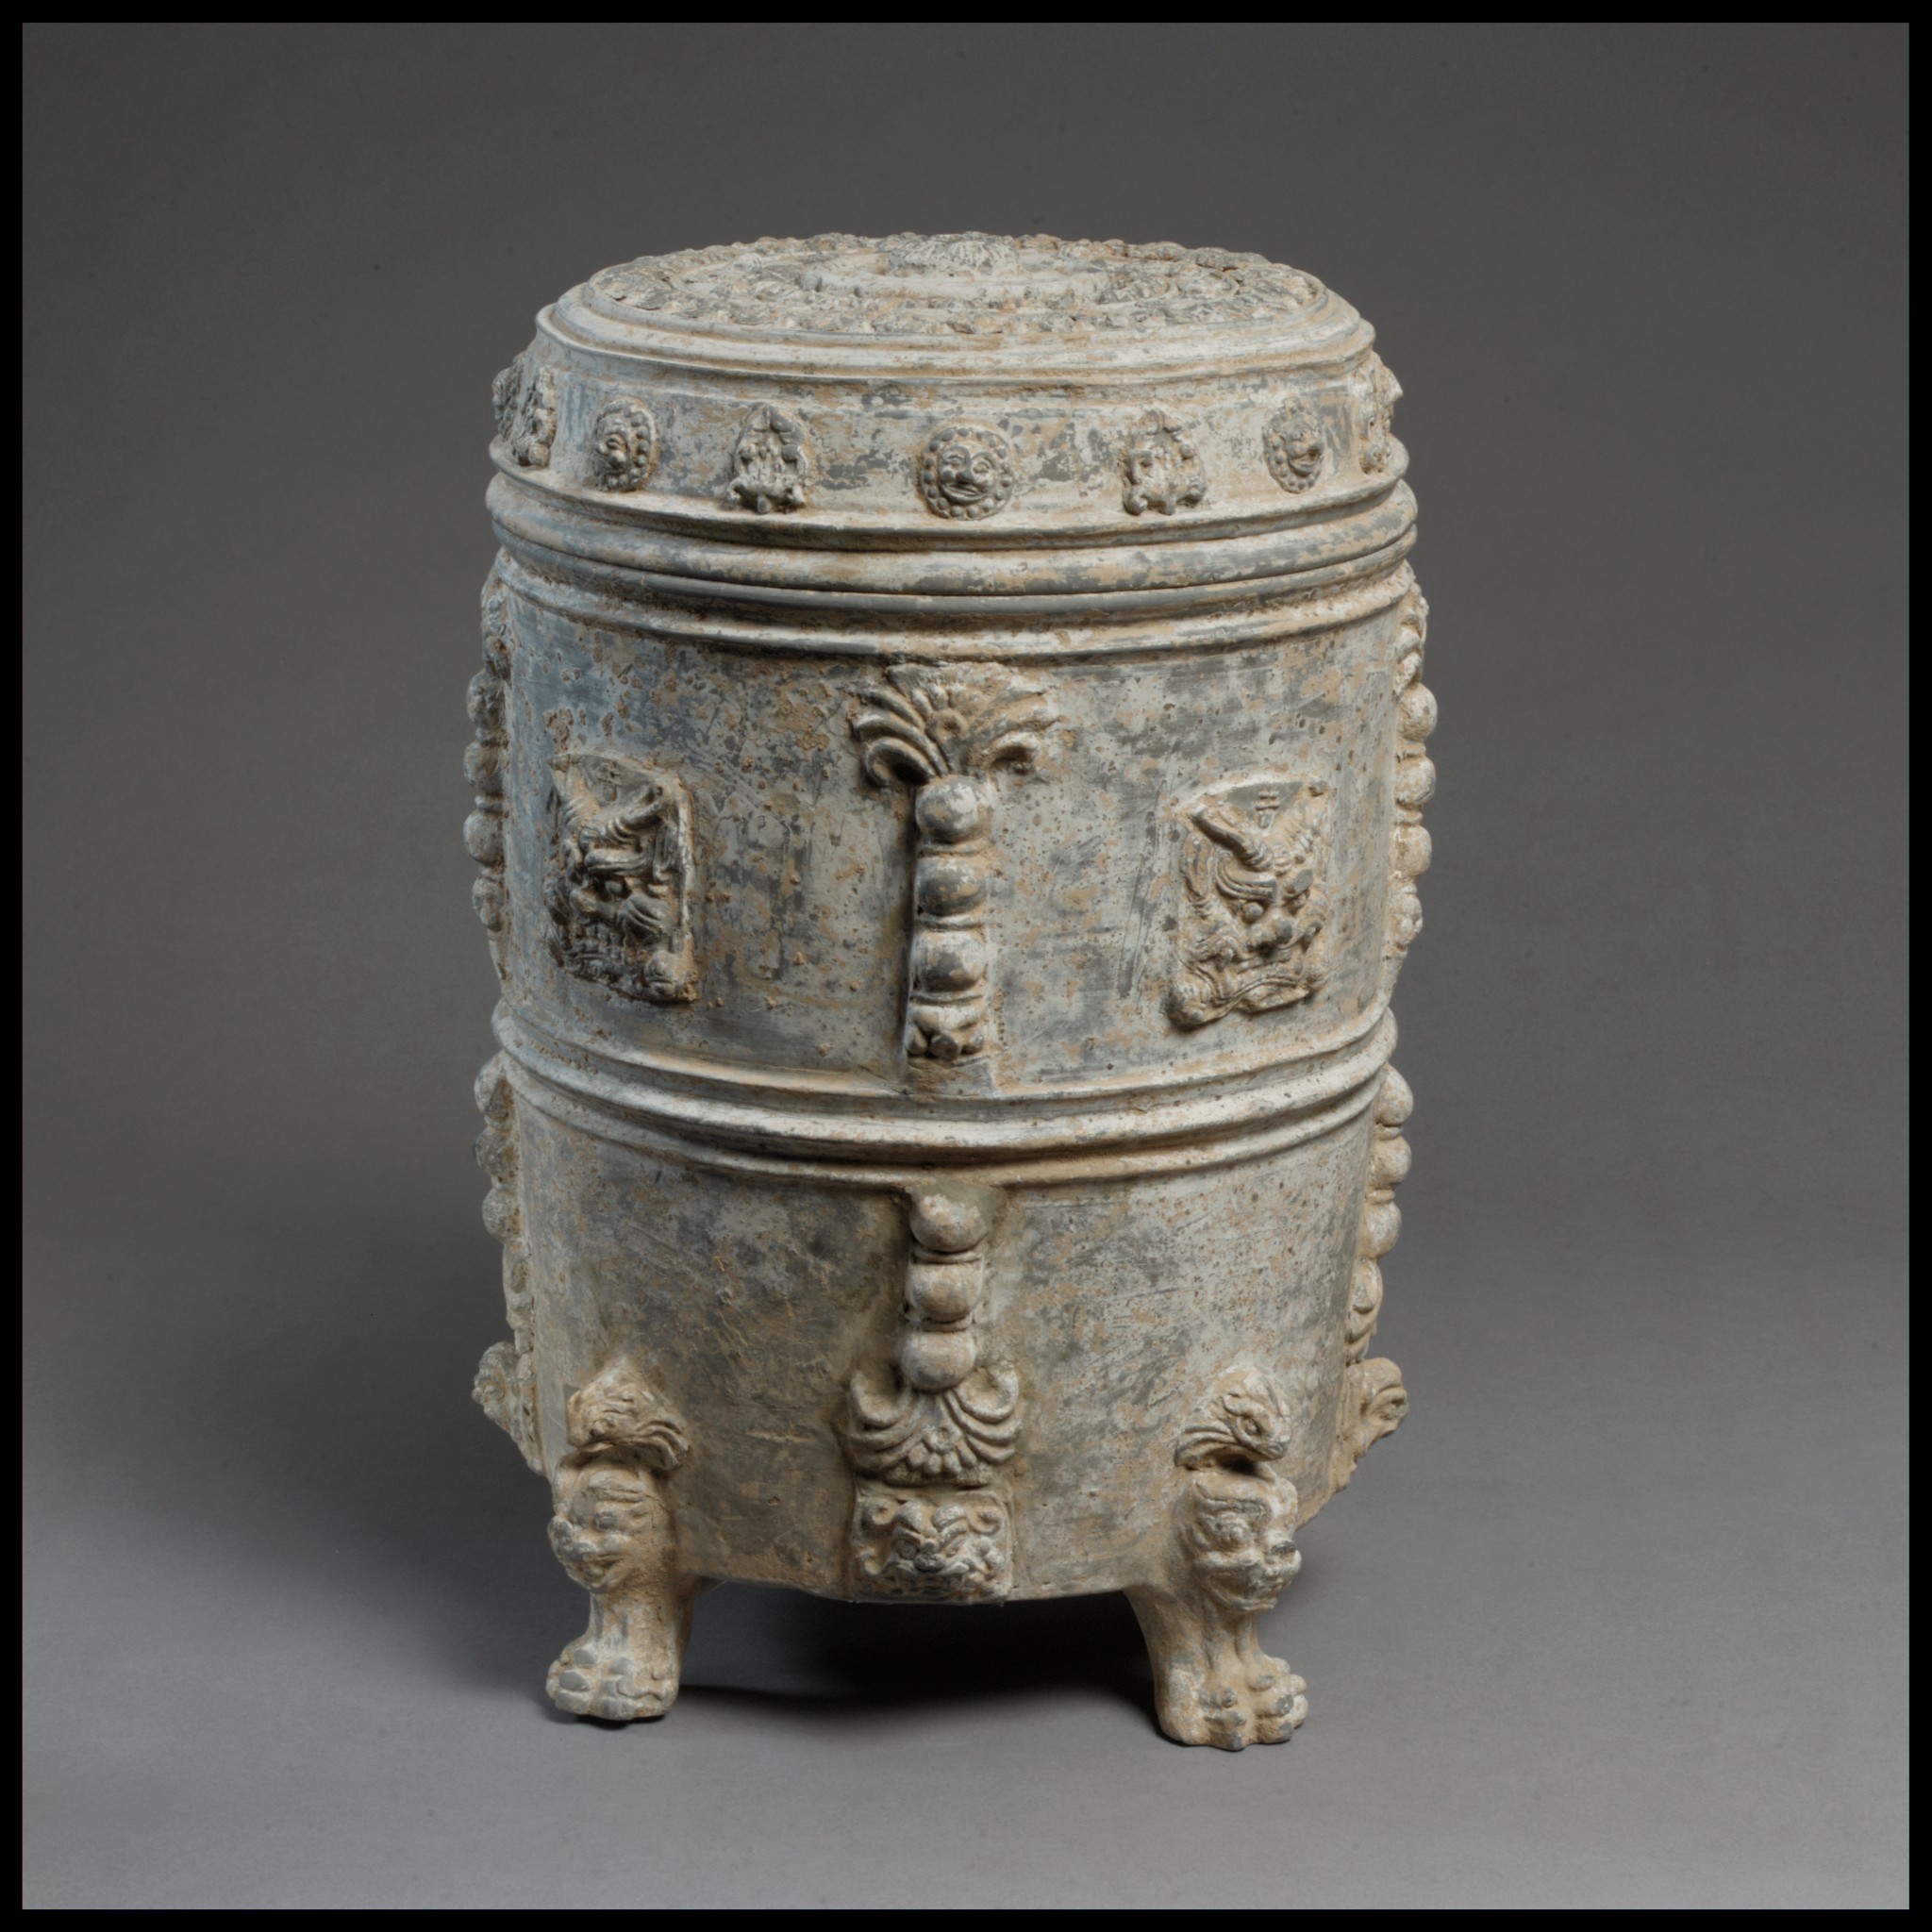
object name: vessel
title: Covered footed vessel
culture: chinese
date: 567-600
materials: earthenware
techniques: relief